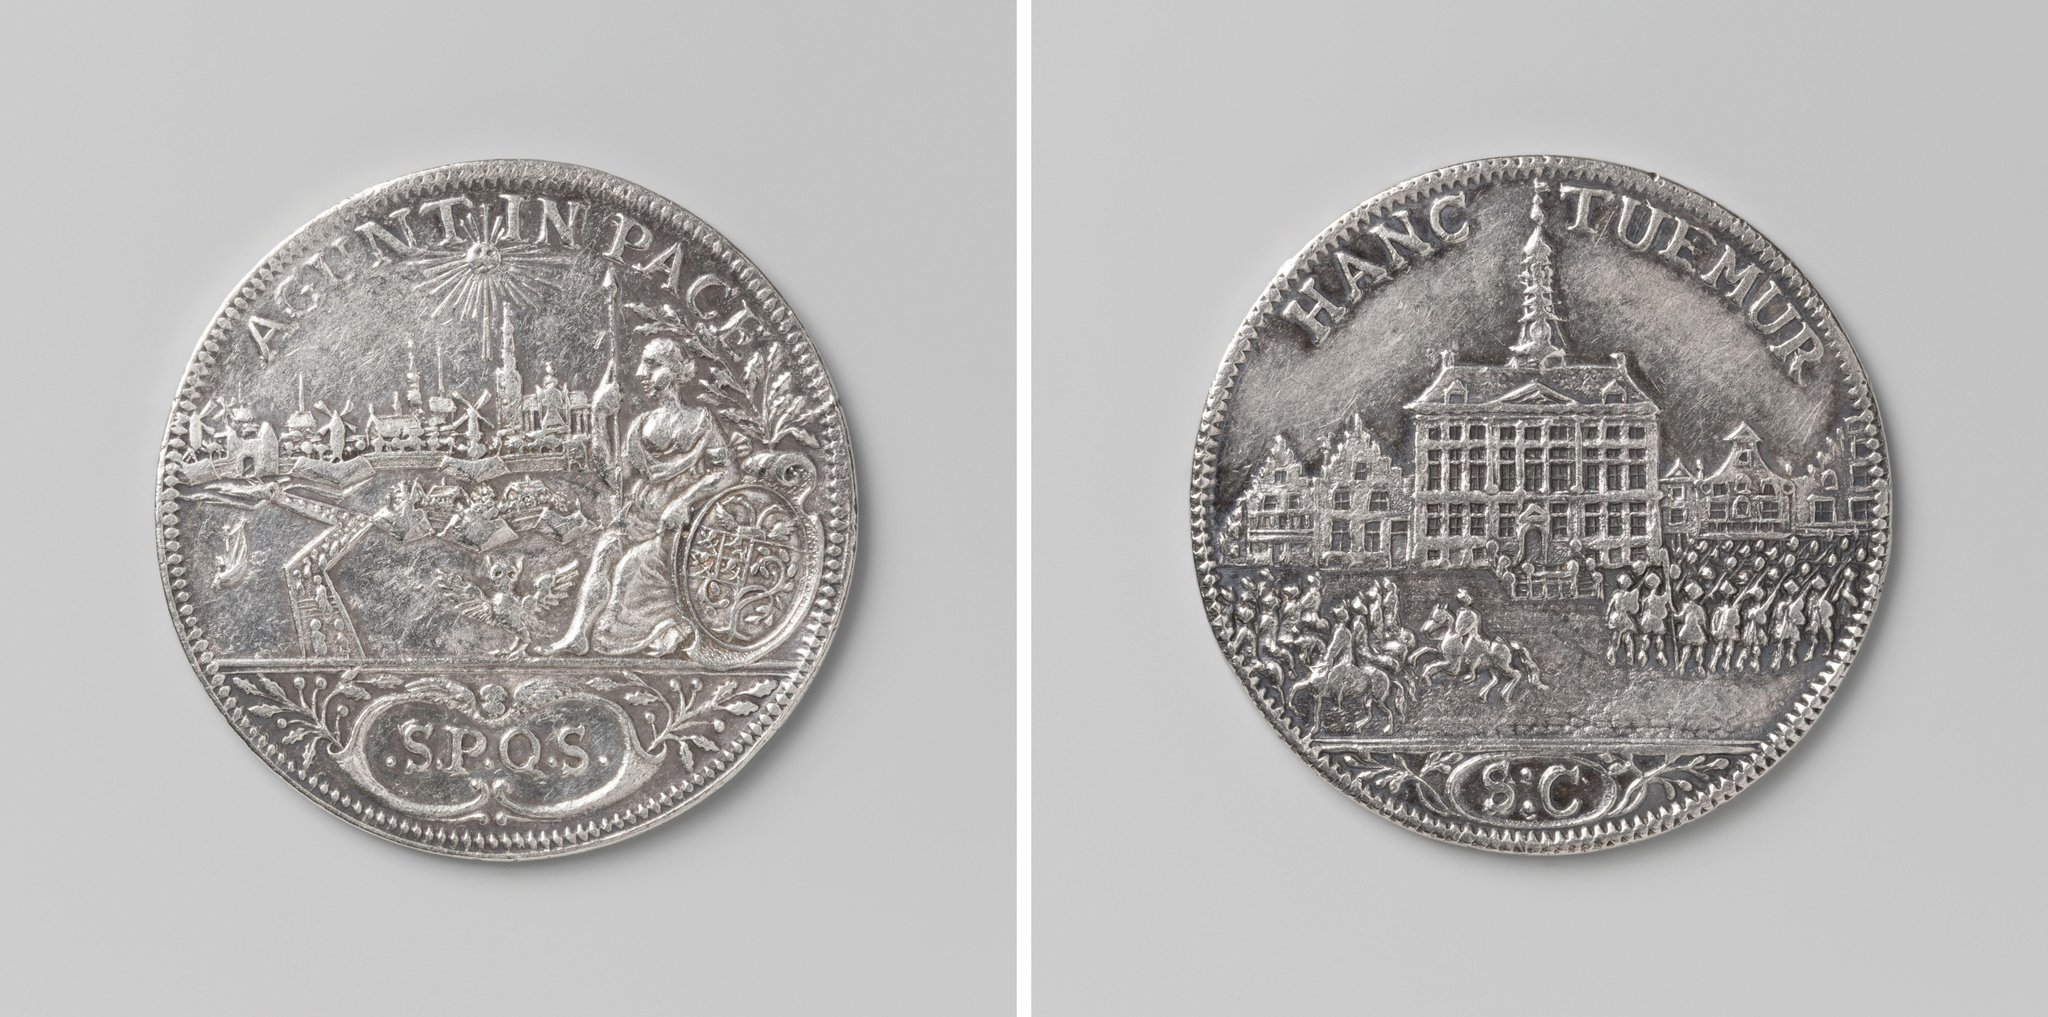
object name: council medal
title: Vroedschapspenning van de stad 's-Hertogenbosch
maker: theodorus casparus van berckel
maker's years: 1680-1734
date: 1714-1720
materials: silver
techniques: striking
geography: den bosch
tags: den bosch